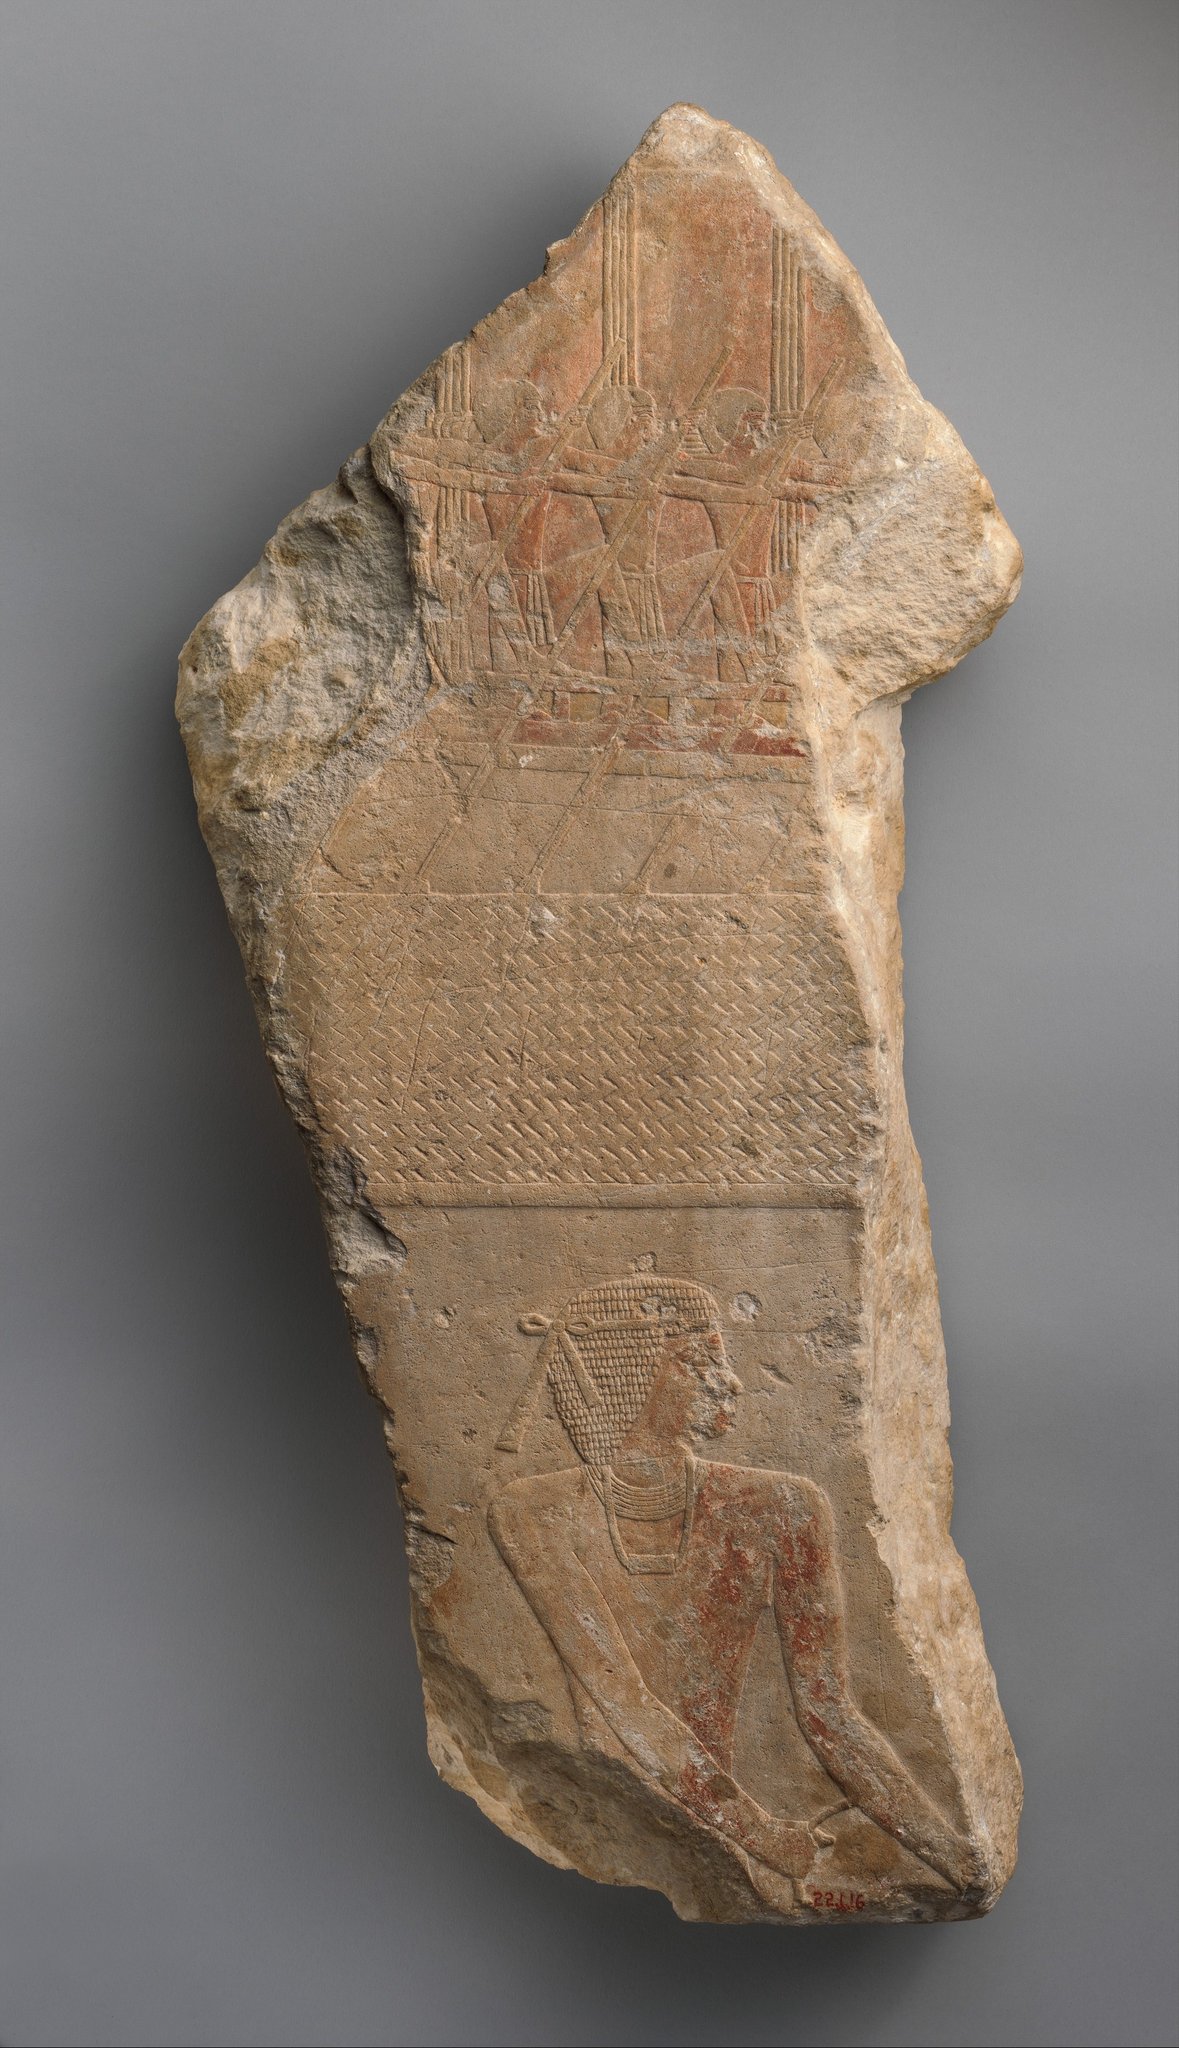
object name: relief, oarsman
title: Oarsmen and an Official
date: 2465-2458 BCE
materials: limestone, paint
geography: egypt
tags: men